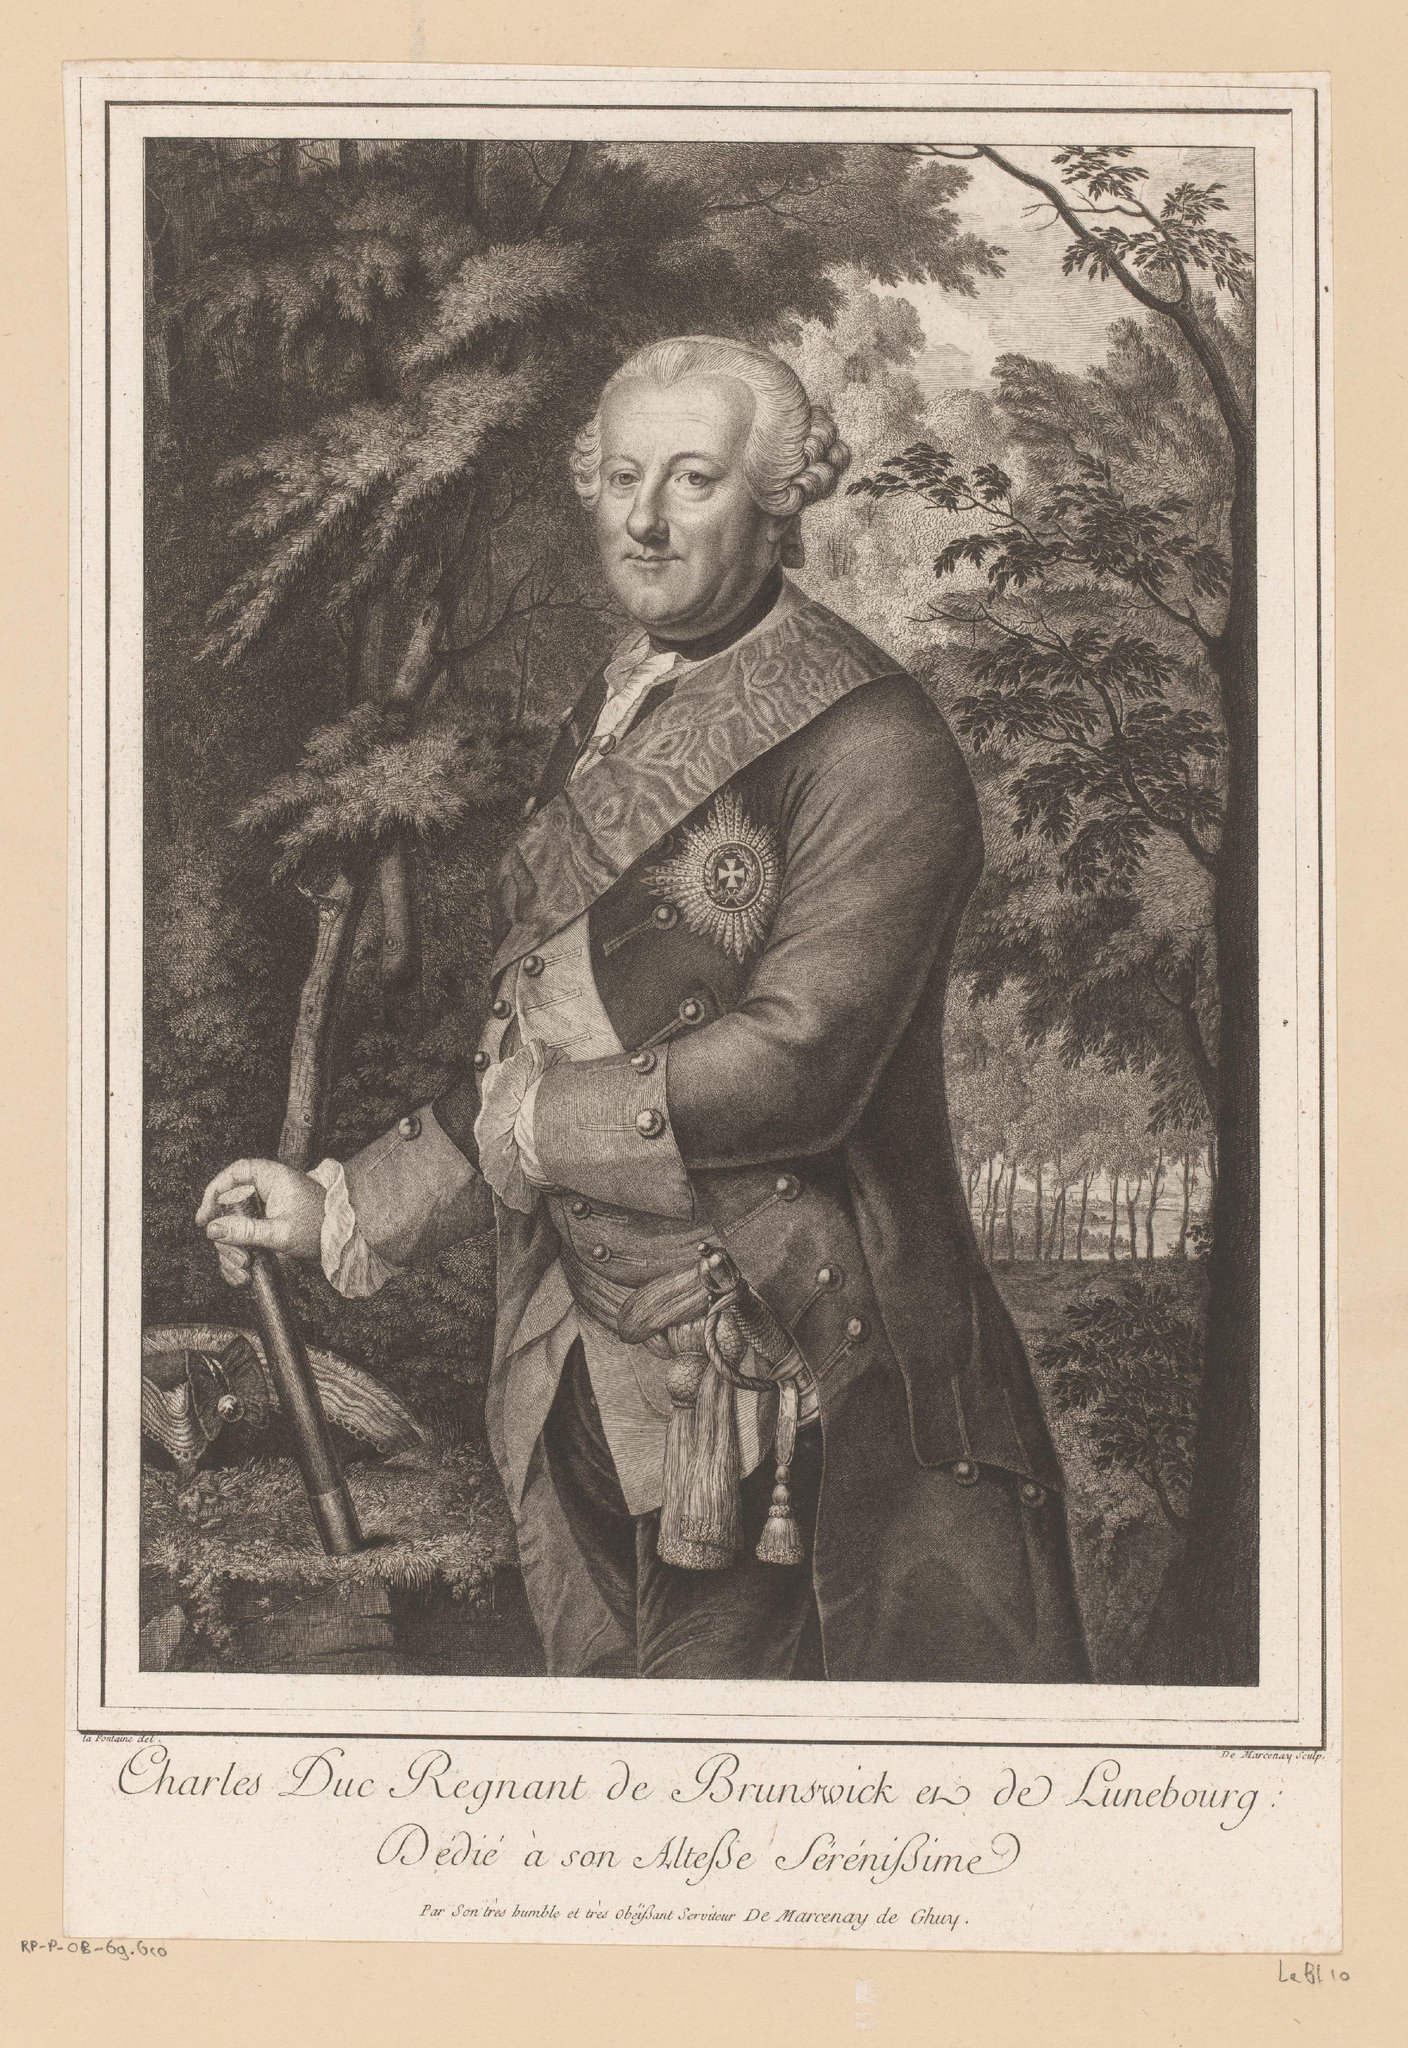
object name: print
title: Portret van Carl I von Braunschweig-Wolfenbüttel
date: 1734-1811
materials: paper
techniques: engraving, etching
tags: carl i von braunschweig-wolfenbüttel, historical persons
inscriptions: collector's mark: Lugt 2228